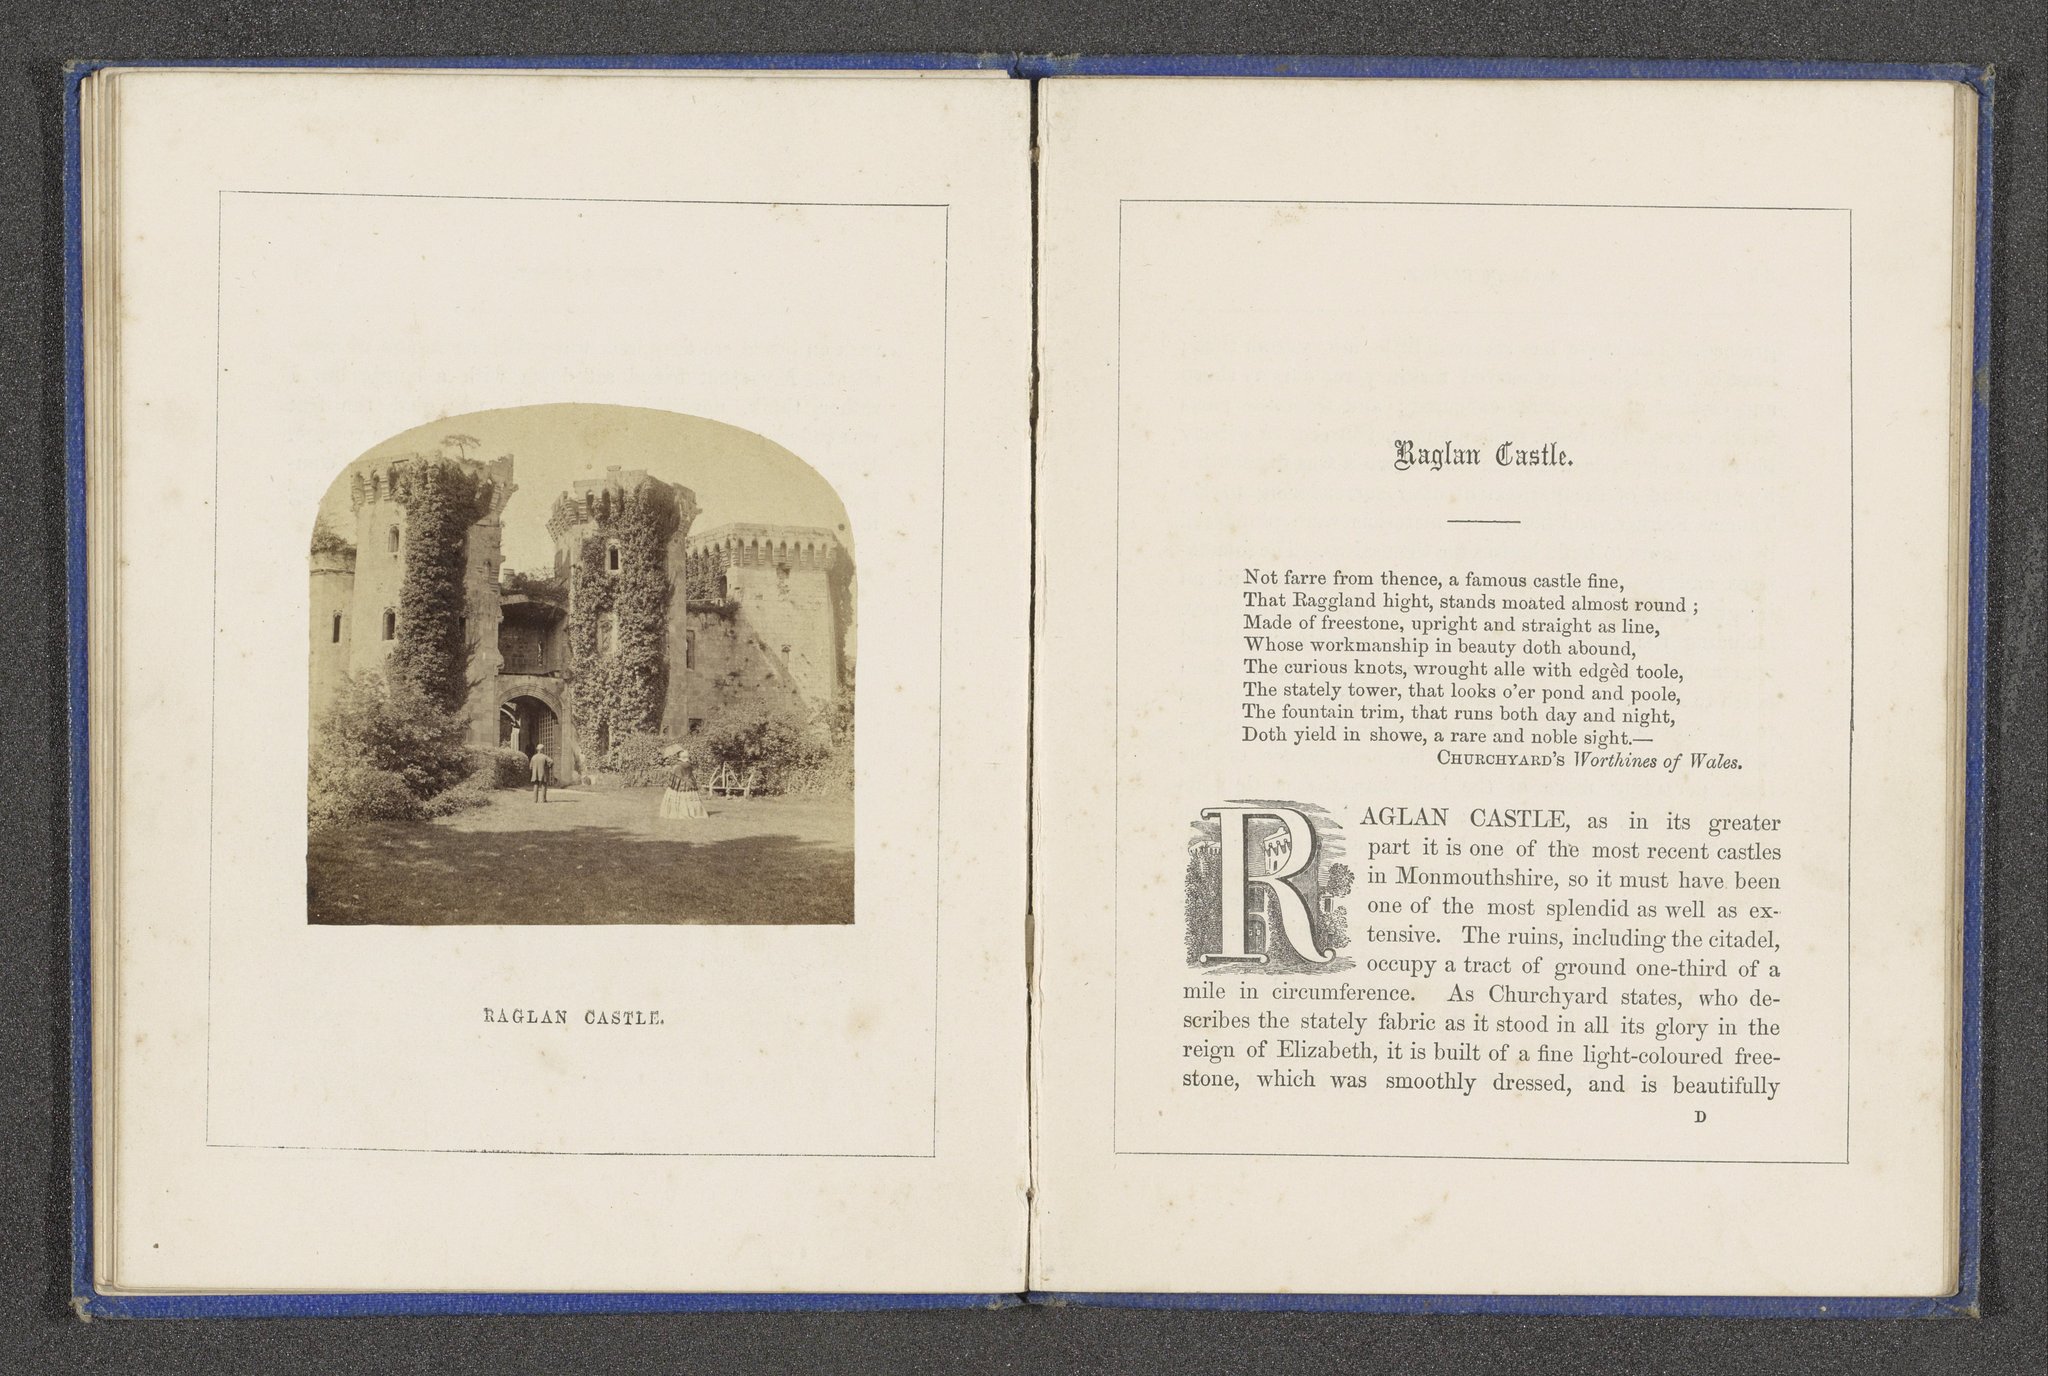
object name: photograph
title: Raglan Castle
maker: francis bedford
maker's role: print maker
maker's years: 1815-1894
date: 1853-1863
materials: photographic support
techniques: albumen print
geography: raglan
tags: gate, entrance, ruin of a dwelling, house, castle, etc.